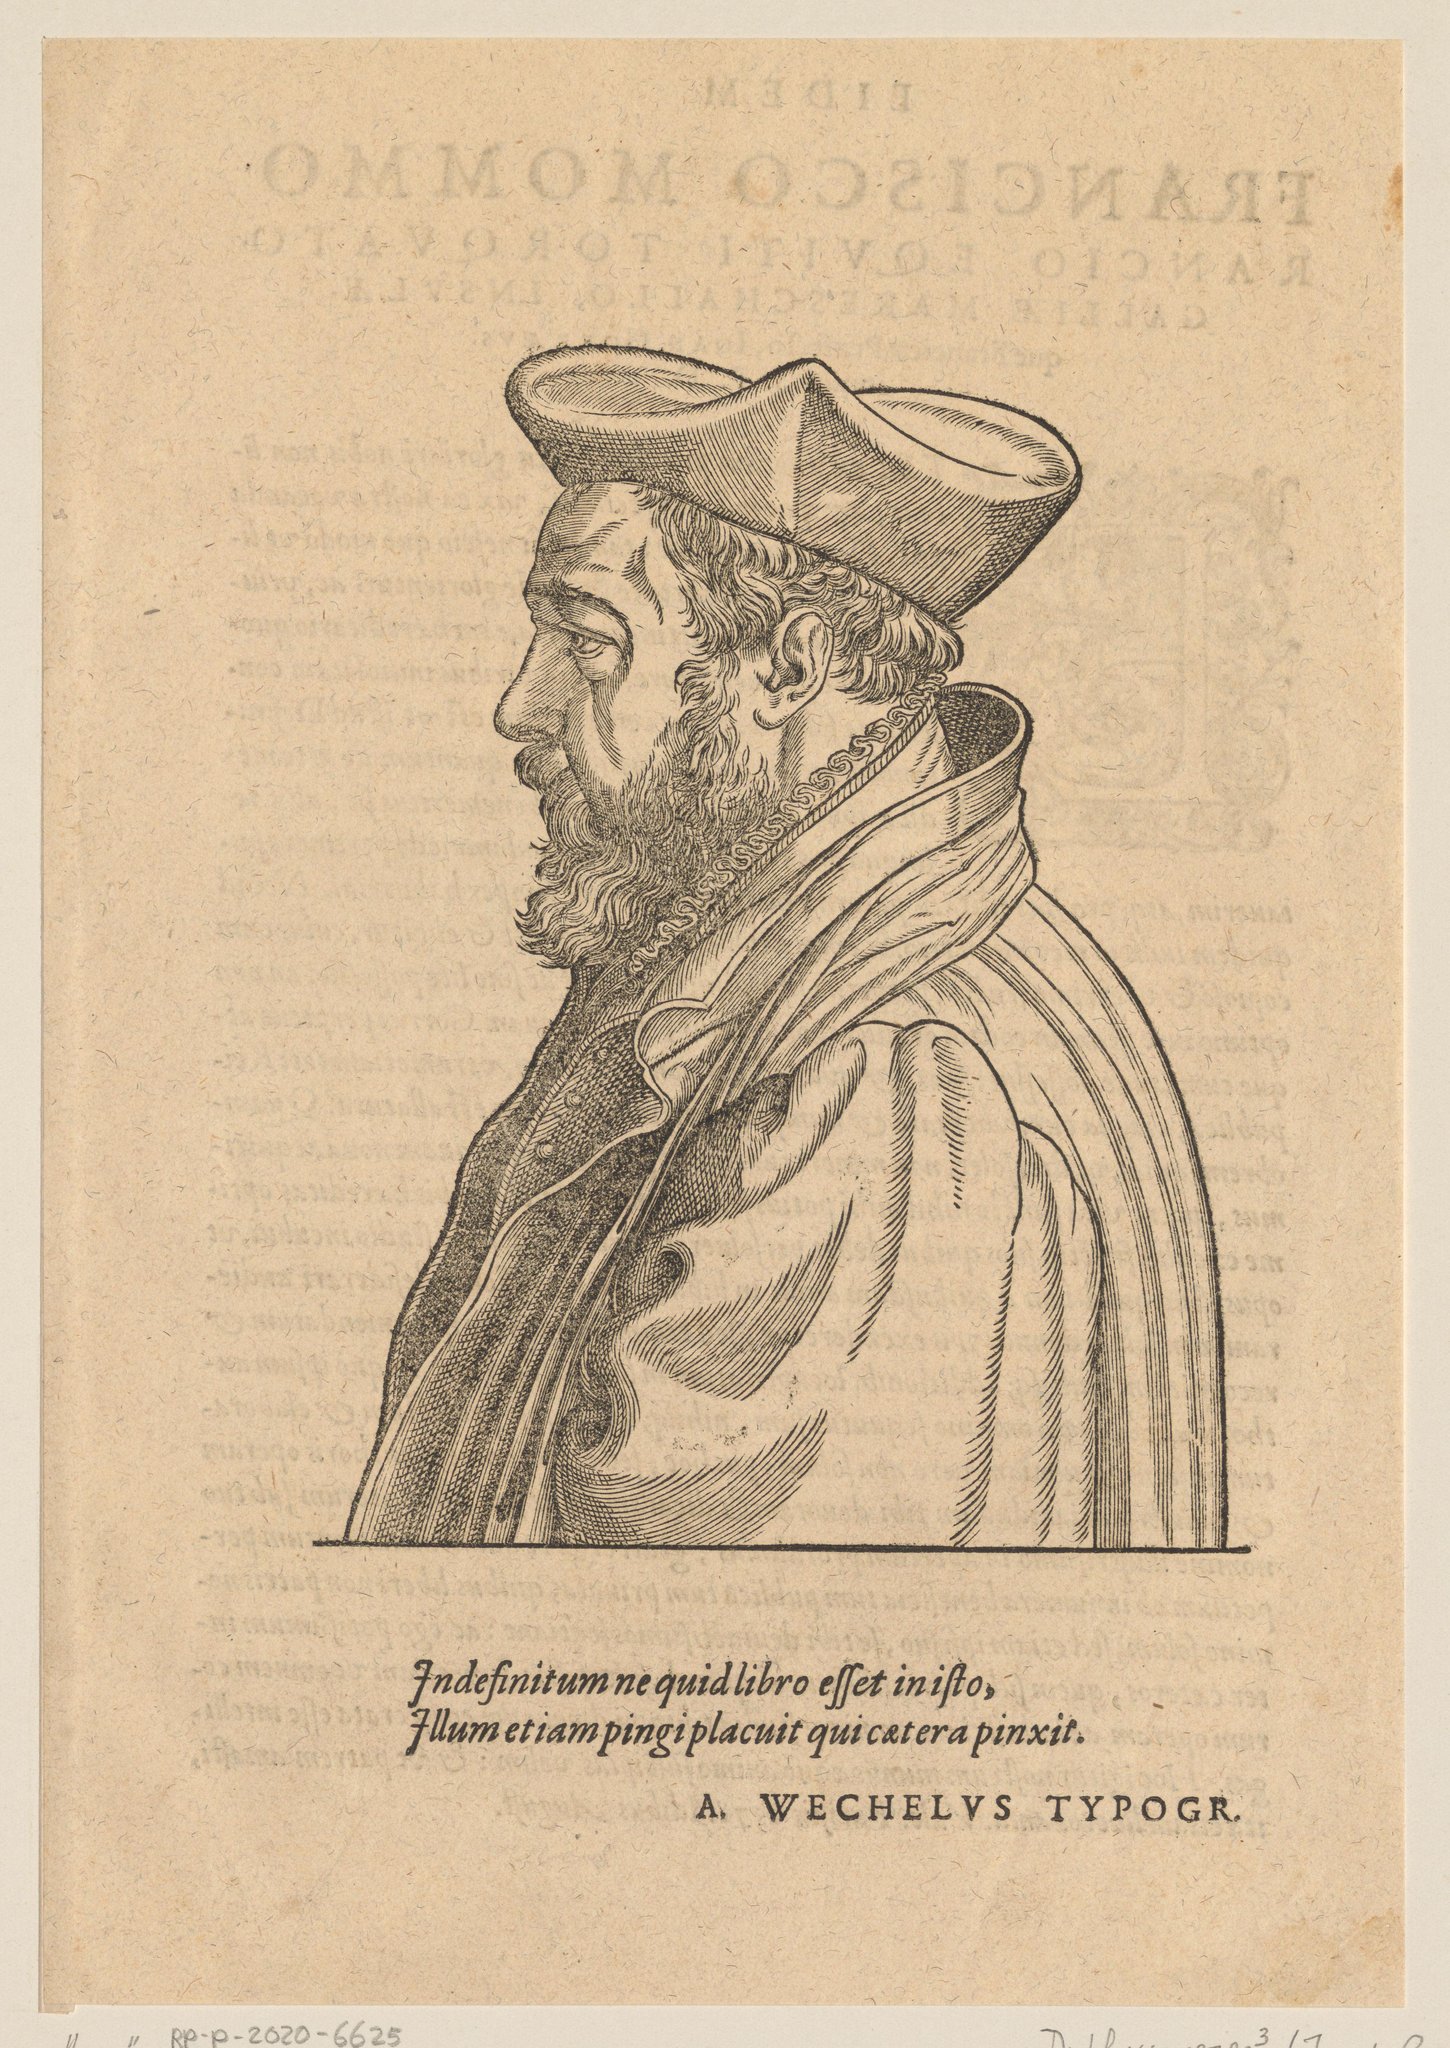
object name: book illustration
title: Portret van Jean de Gorris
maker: andré wechel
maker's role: publisher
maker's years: 1510-1581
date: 1564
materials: paper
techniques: letterpress printing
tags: paris, historical persons, physician, doctor (+ portrait of scholar, scientist)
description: Prent uit een onbekende editie van: Gorris, Jean de. Io. Gorræi Parisiensis Definitionum medicarum libri XXIIII. Frankfurt am Main: André Wechel en [erven] Claude de Marne, [1564].